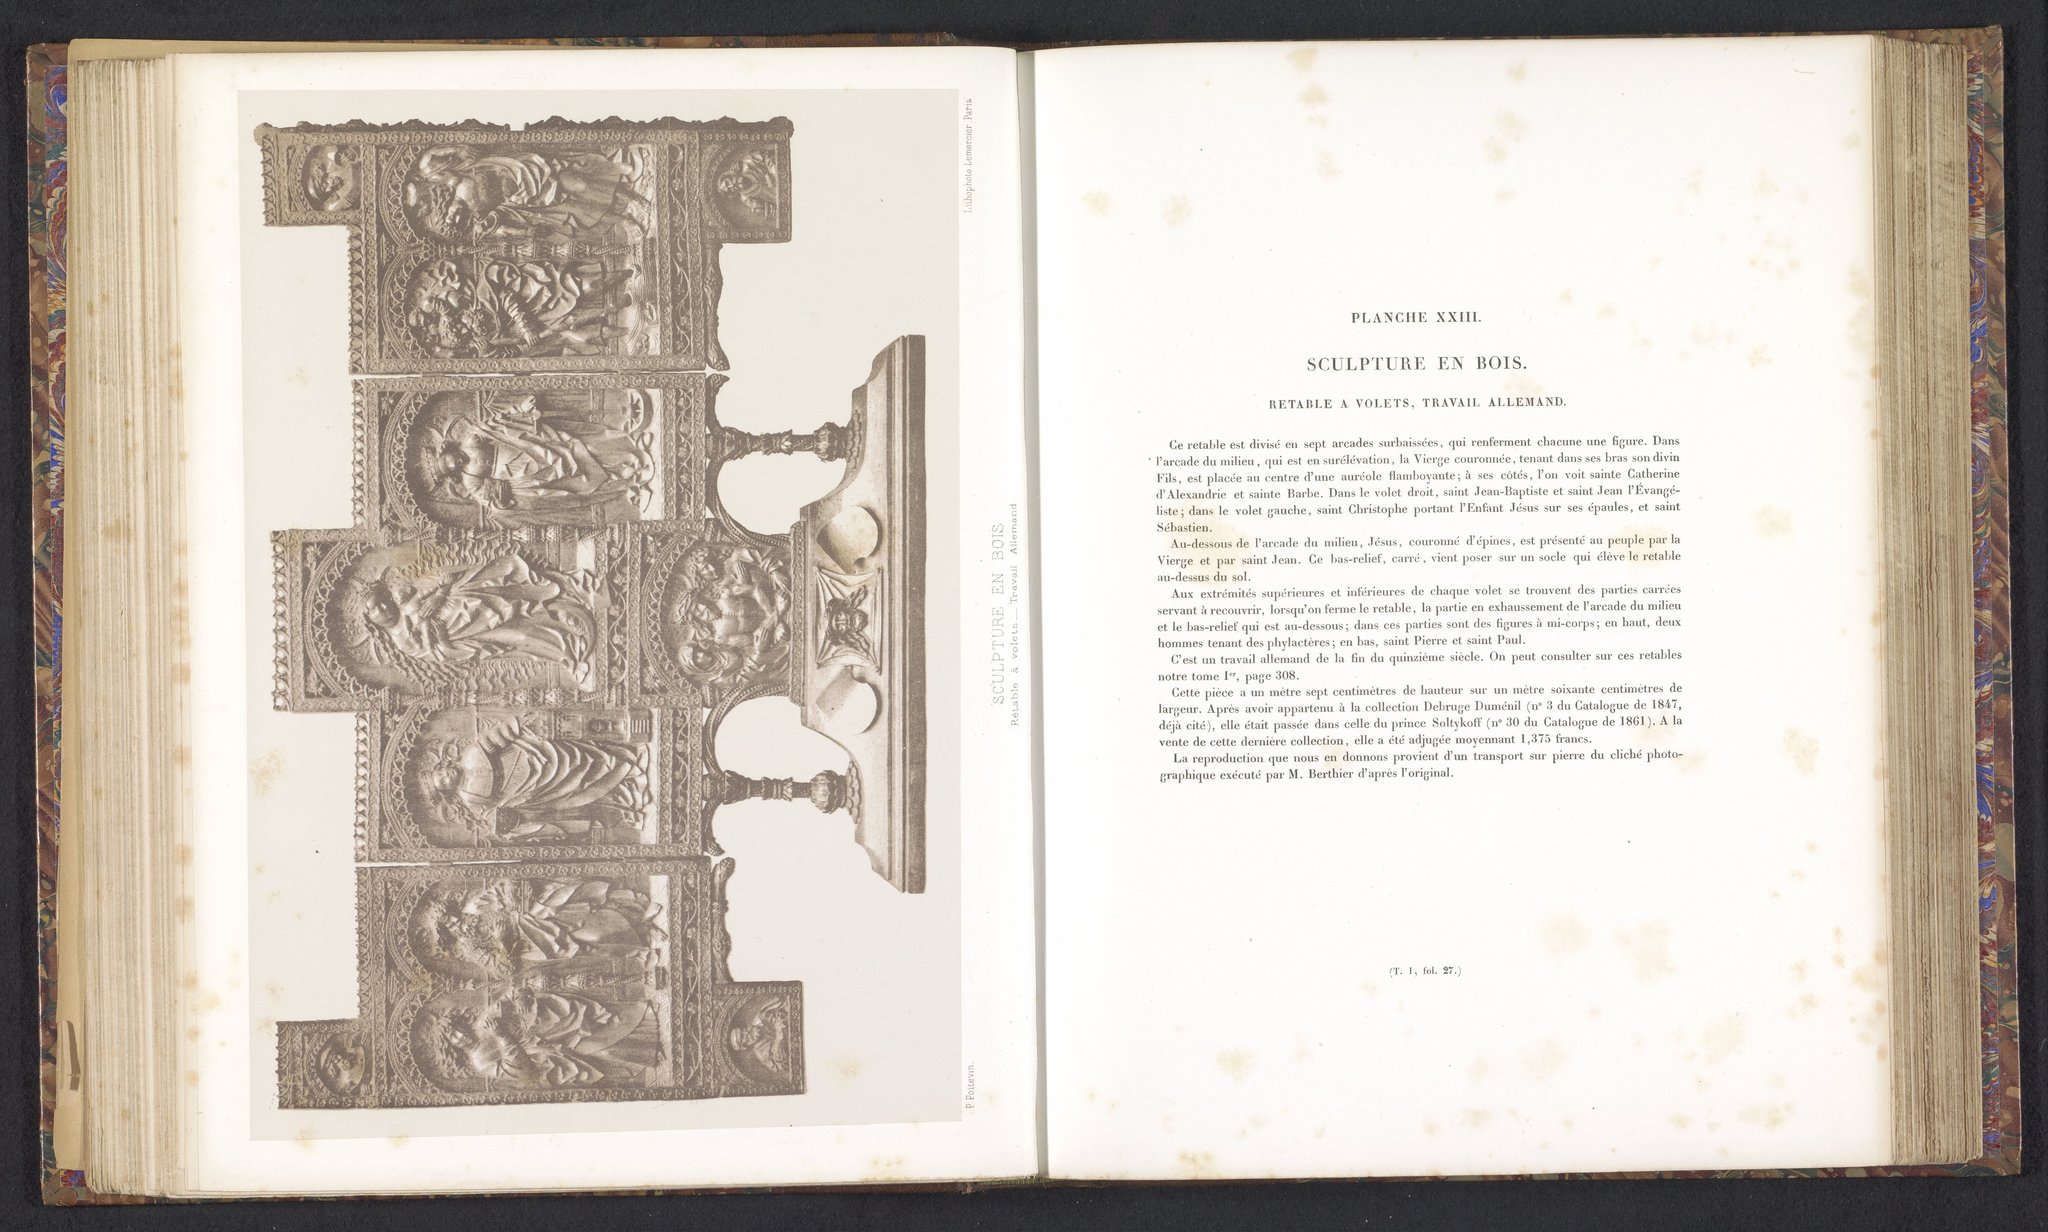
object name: photomechanical print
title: Houten vleugelaltaar met reliëfs, voorstellende Maria met Kind en heiligen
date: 1859-1864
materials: paper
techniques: photolithography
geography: paris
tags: madonna: i.e. mary with the christ-child, saints, altar, sculpture (+ relief ~ sculpture)